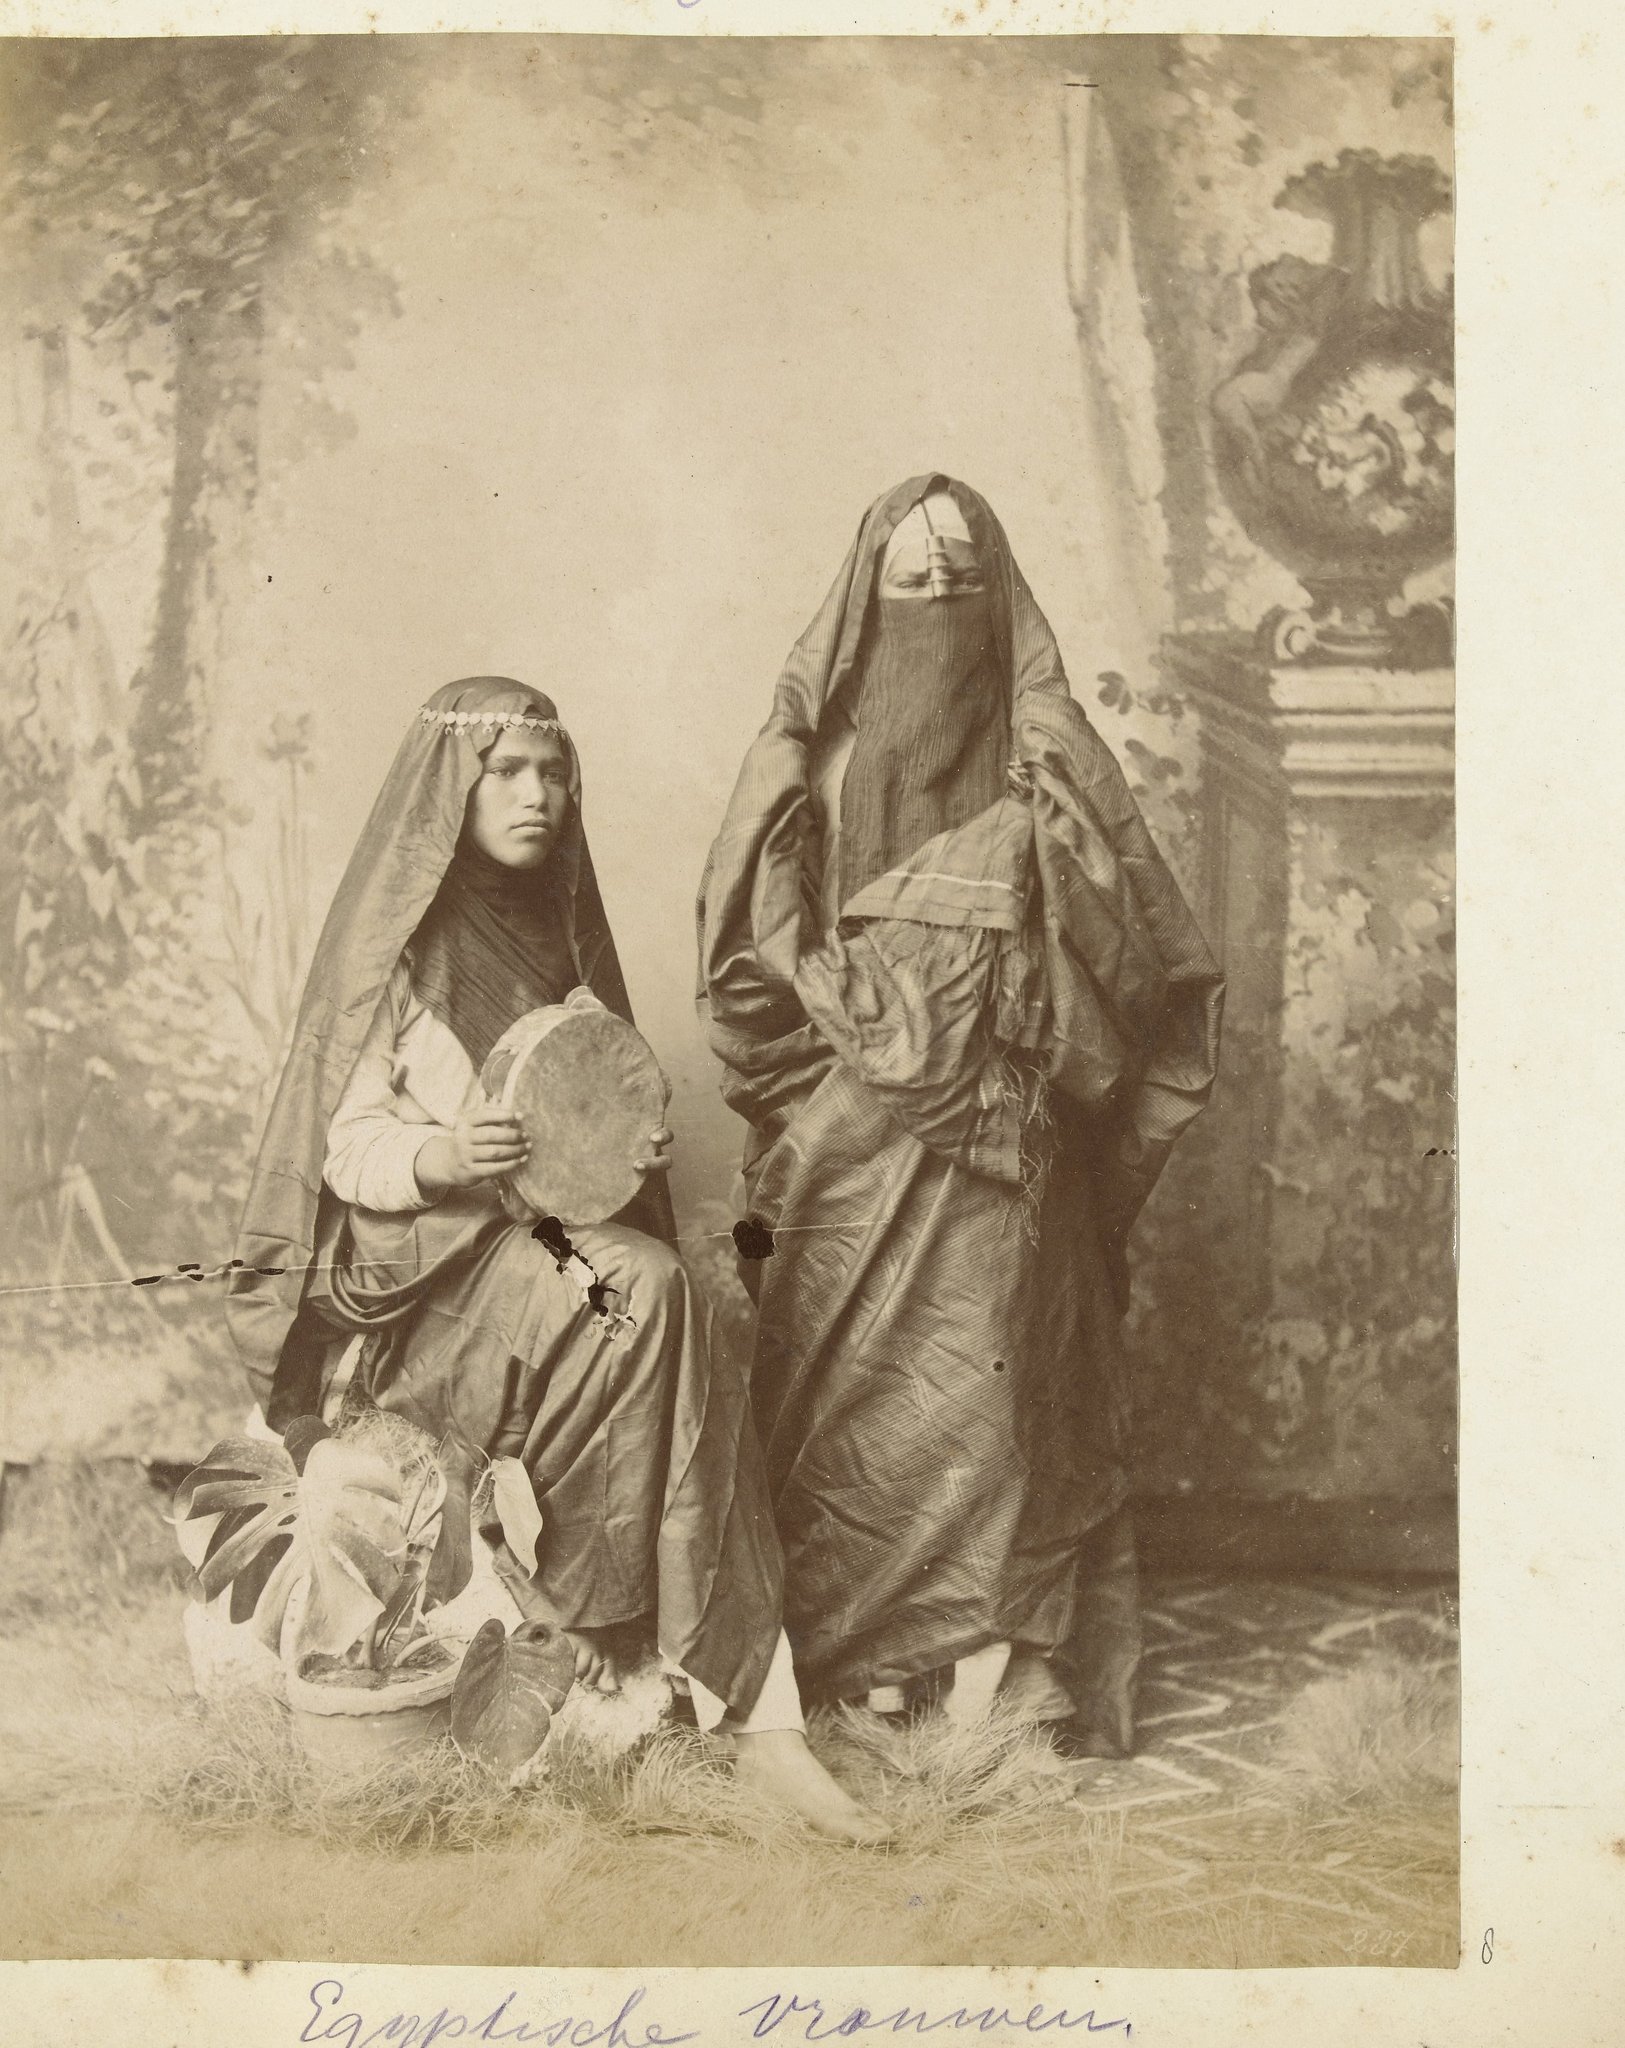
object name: photograph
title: Studioportret van twee gesluierde vrouwen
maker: Anonymous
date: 1890-1910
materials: cardboard, paper, photographic support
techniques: gelatin silver print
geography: netherlands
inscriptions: caption: ‘Egyptische vrouwen’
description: De linker vrouw heeft een tamboerijn in de hand, de rechter vrouw draagt een sluier over haar gezicht.